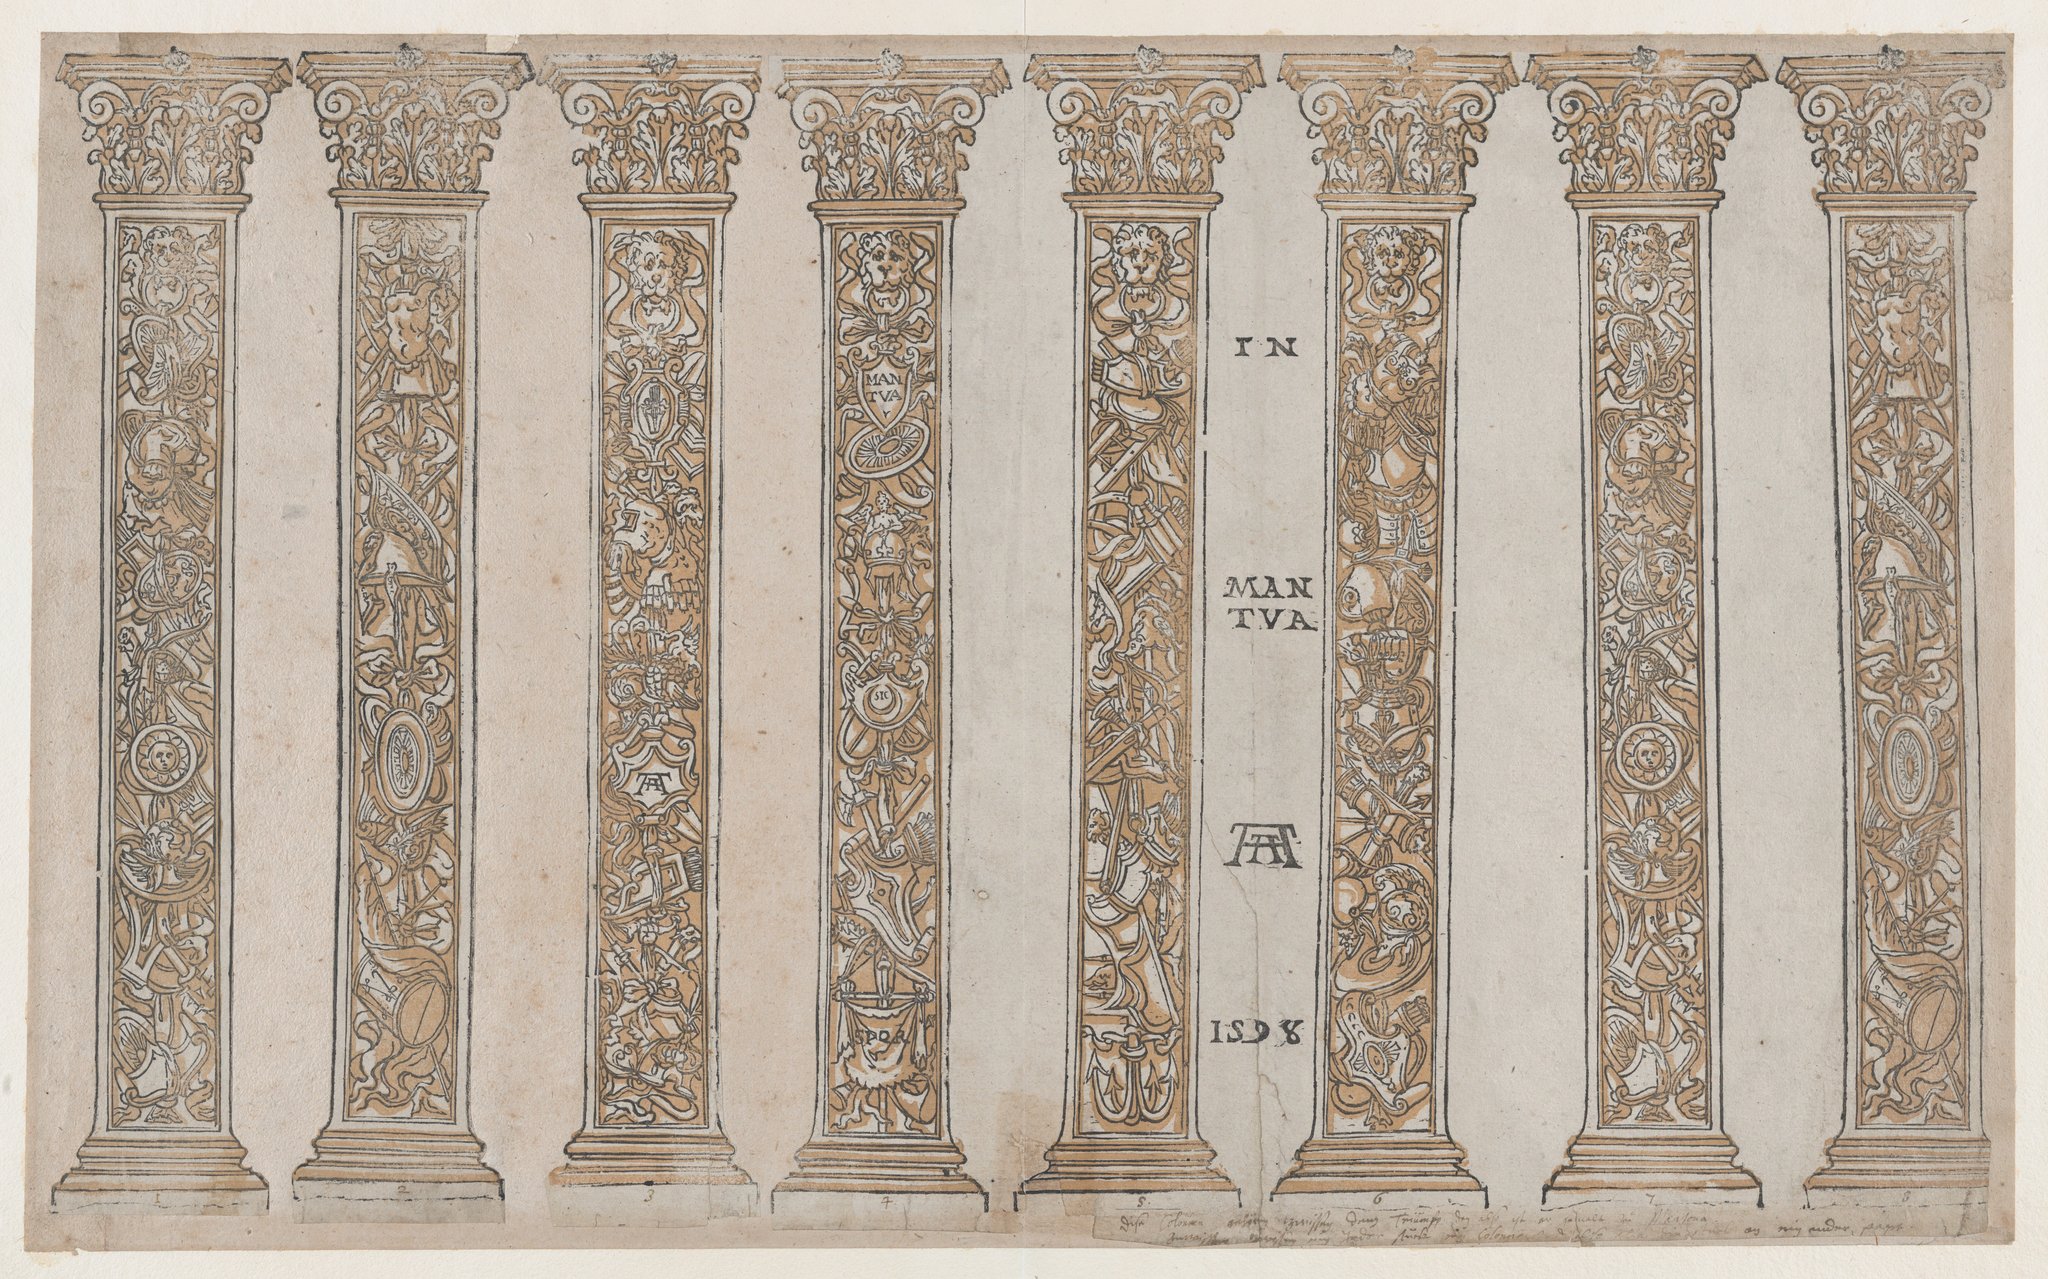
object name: print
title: Six Corinthian pilasters for the Triumph, from "The Triumph of Julius Caesar"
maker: andrea andreani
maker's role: artist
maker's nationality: italian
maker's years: 1558-1629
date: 1598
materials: ink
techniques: woodcut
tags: pilasters